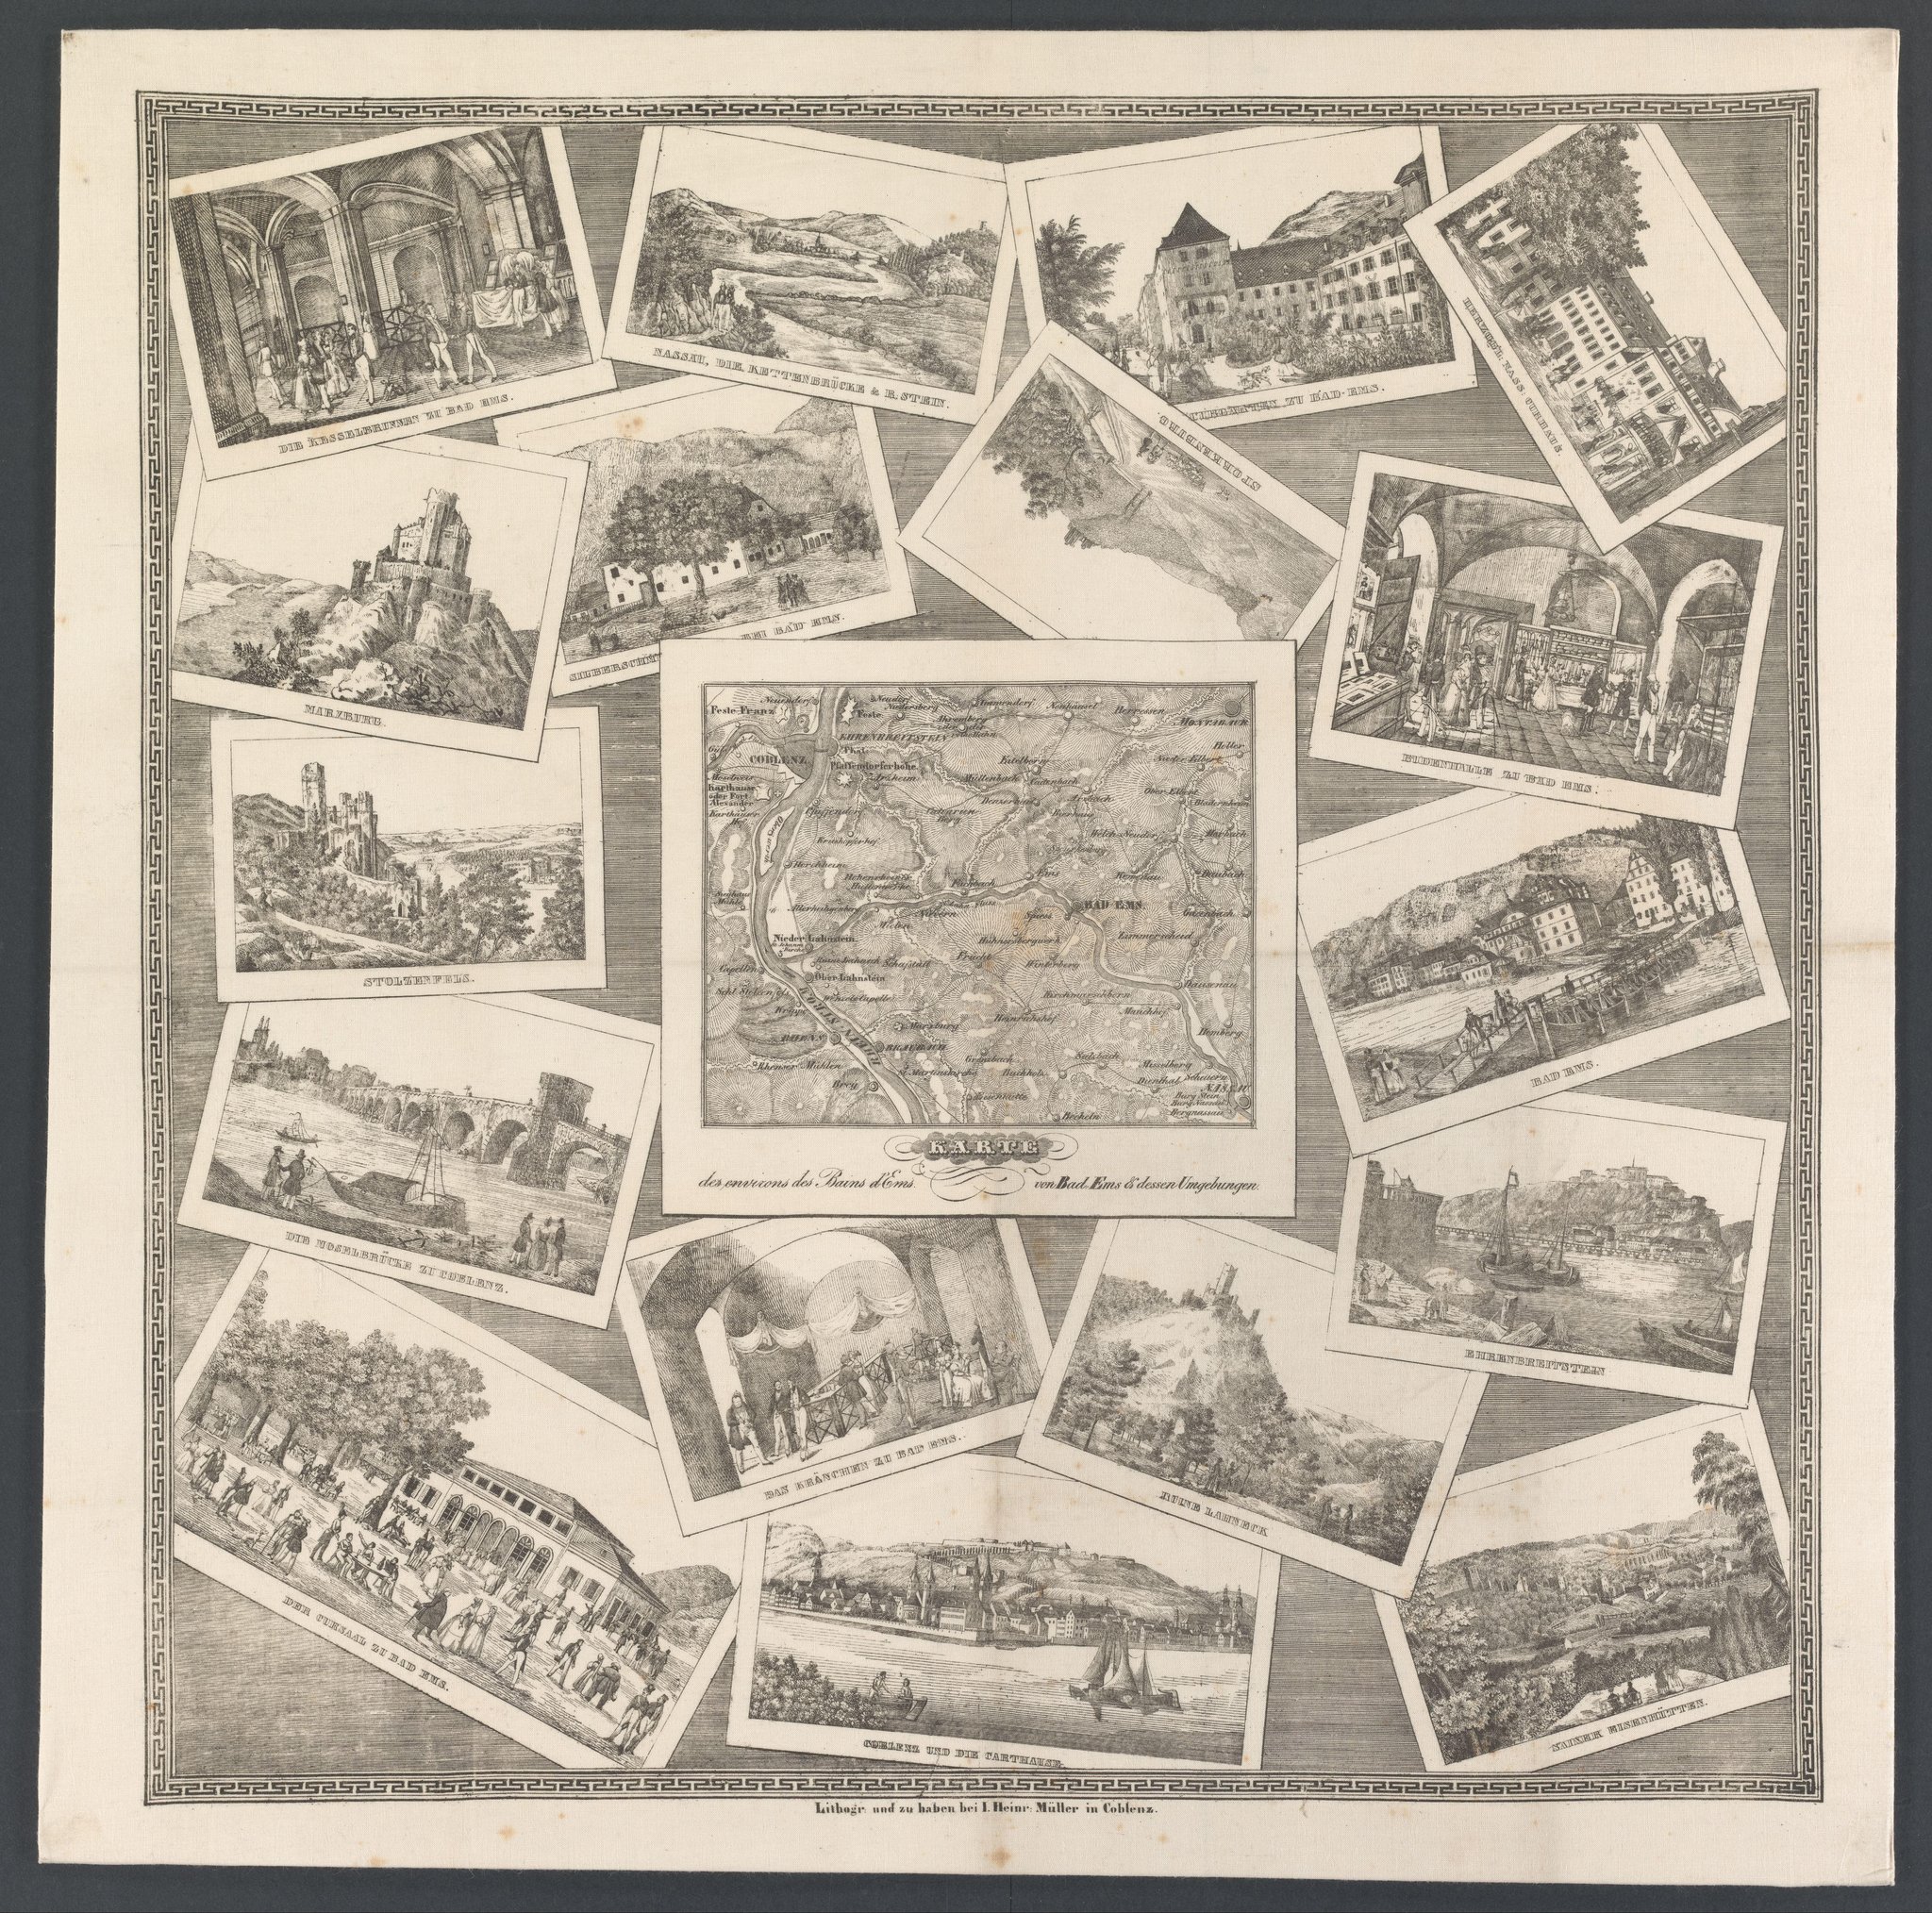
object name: print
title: Karte von Bad Ems & dessen Umgebungen / Des environs des Bains d'Ems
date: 1820-1875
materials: canvas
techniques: lithograph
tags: maps, atlases, city-view, and landscape with man-made constructions (+ city(-scape) with figures, staffage)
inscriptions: collector's mark: Lugt 2228